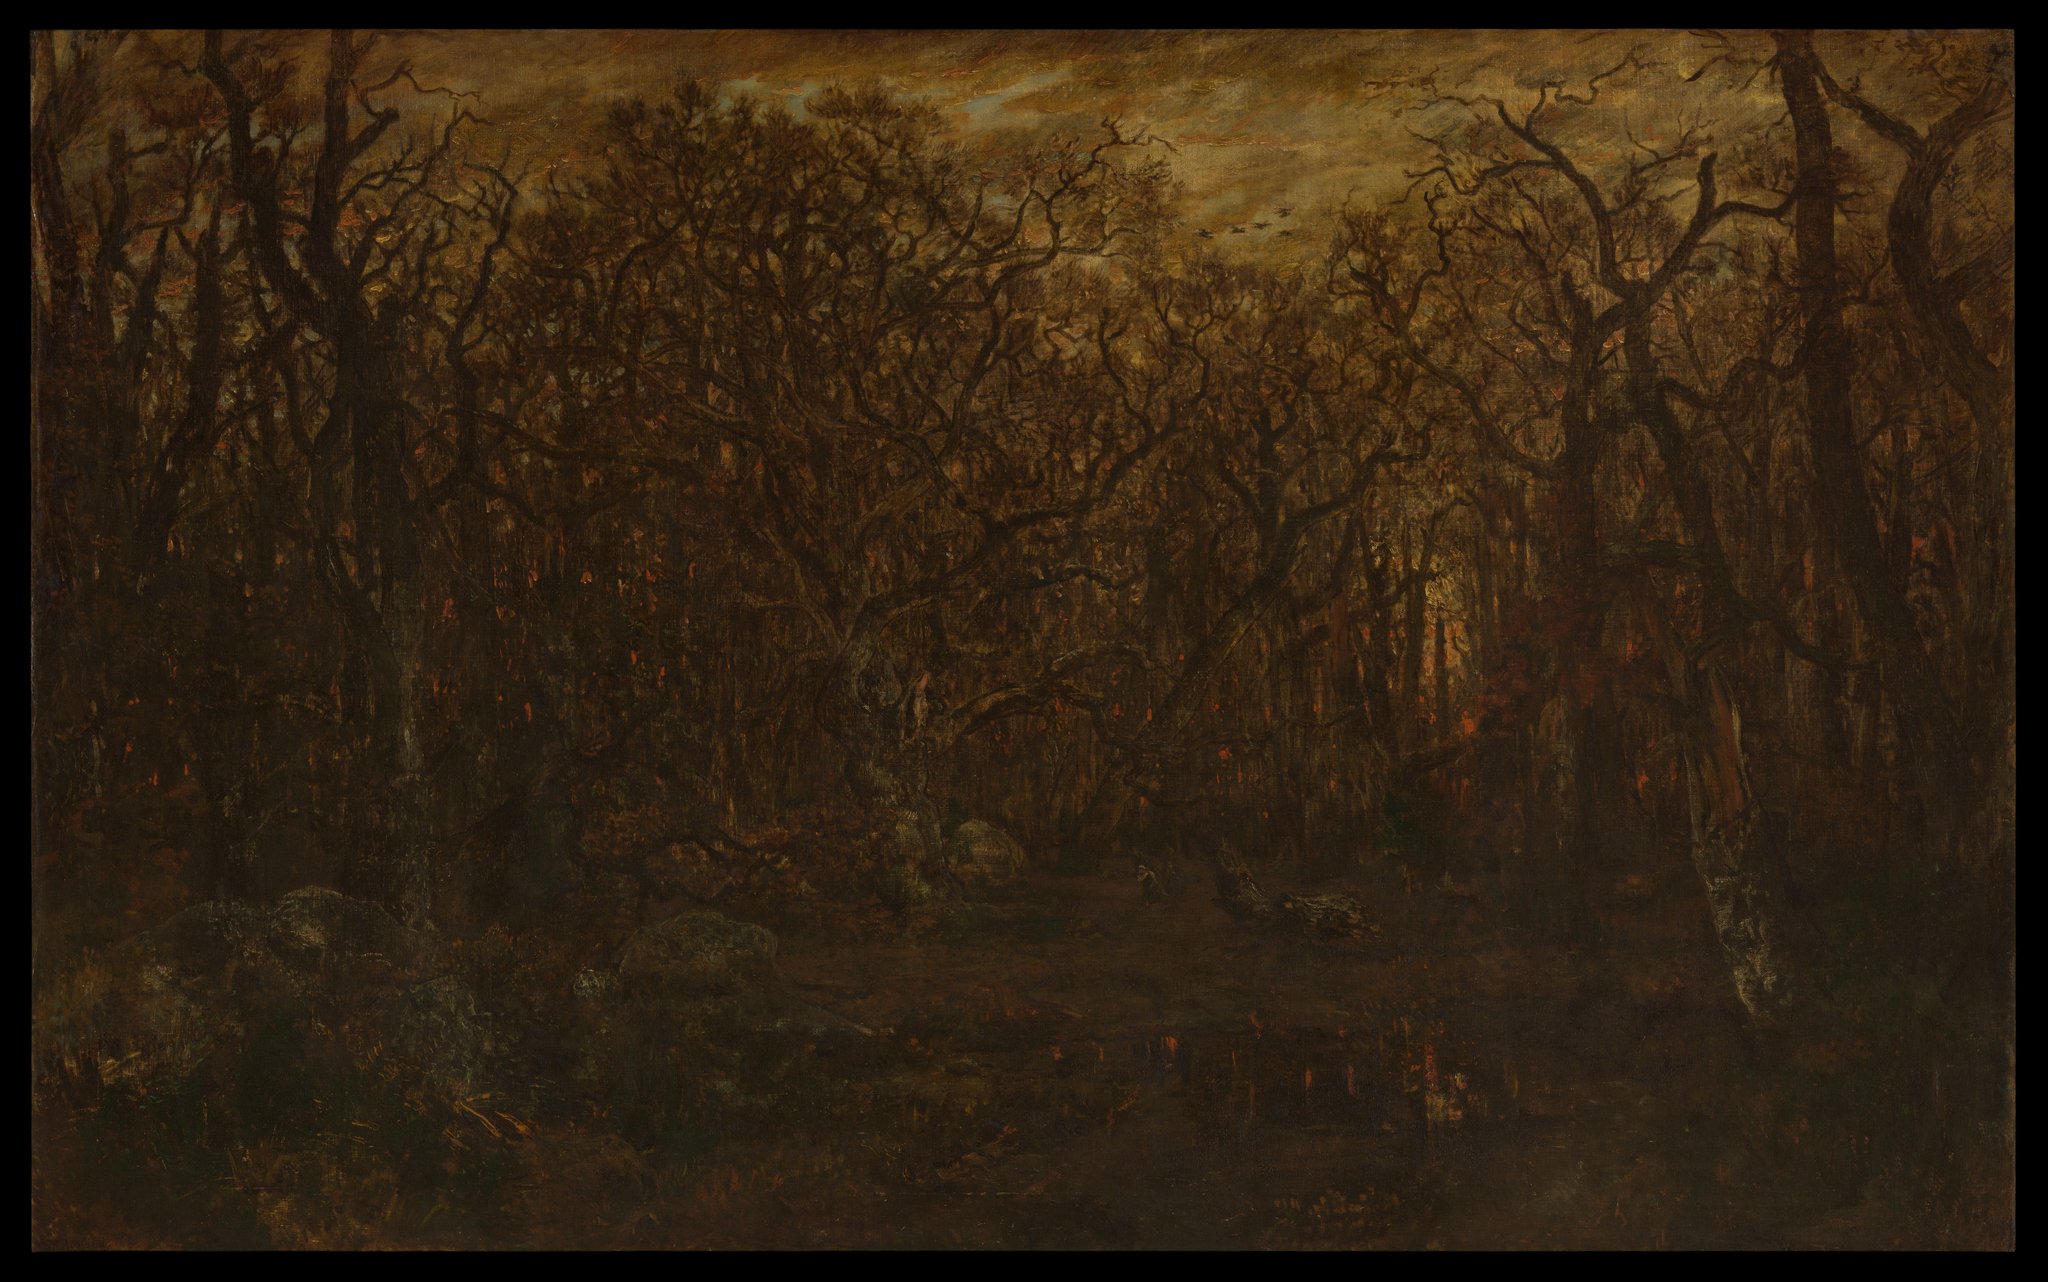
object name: painting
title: The Forest in Winter at Sunset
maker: théodore rousseau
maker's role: artist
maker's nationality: french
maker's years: 1812-1867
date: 1846-1867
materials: canvas, oil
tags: forests,winter,evening